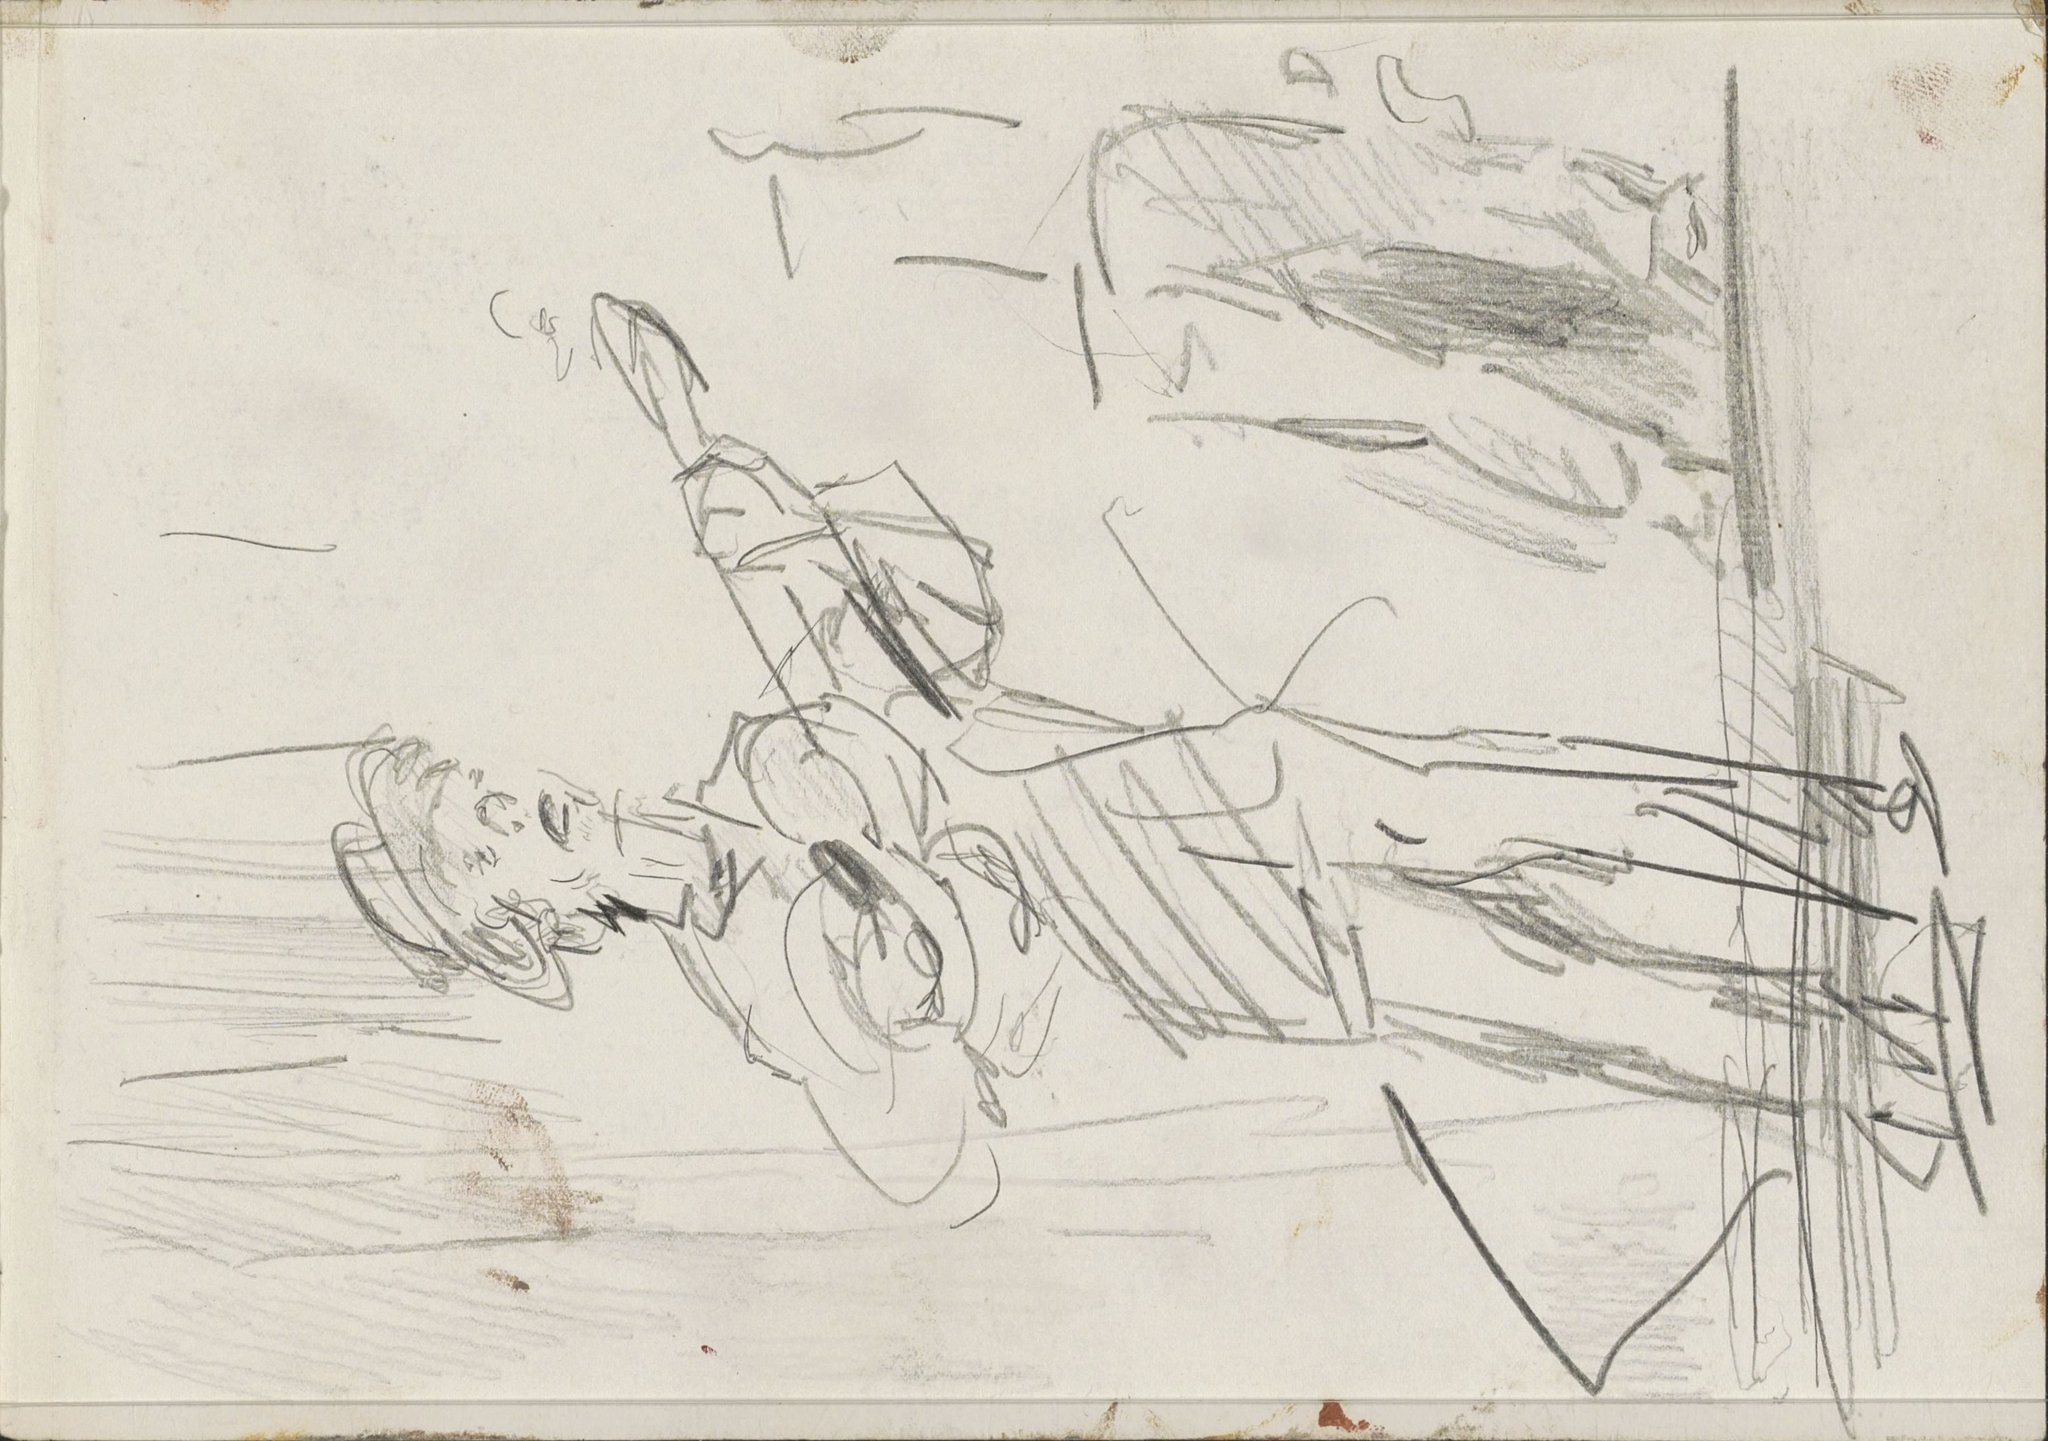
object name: sketchbook leaf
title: Gitaarspeler met hoed op een toneel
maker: isaac israels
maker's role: draughtsman, painter, print maker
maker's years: 1865-1934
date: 1930-1934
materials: paper, pencil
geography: the hague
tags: cithern, mandolin, guitar, balalaika (+ artist at work), the stage and its equipment (+ artist at work)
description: De man speelt gitaar of een aanverwant snaarinstrument. Mogelijk in Theater Scala te Den Haag. Schutblad B, achterste schutblad, uit schetsboek I met 26 bladen.